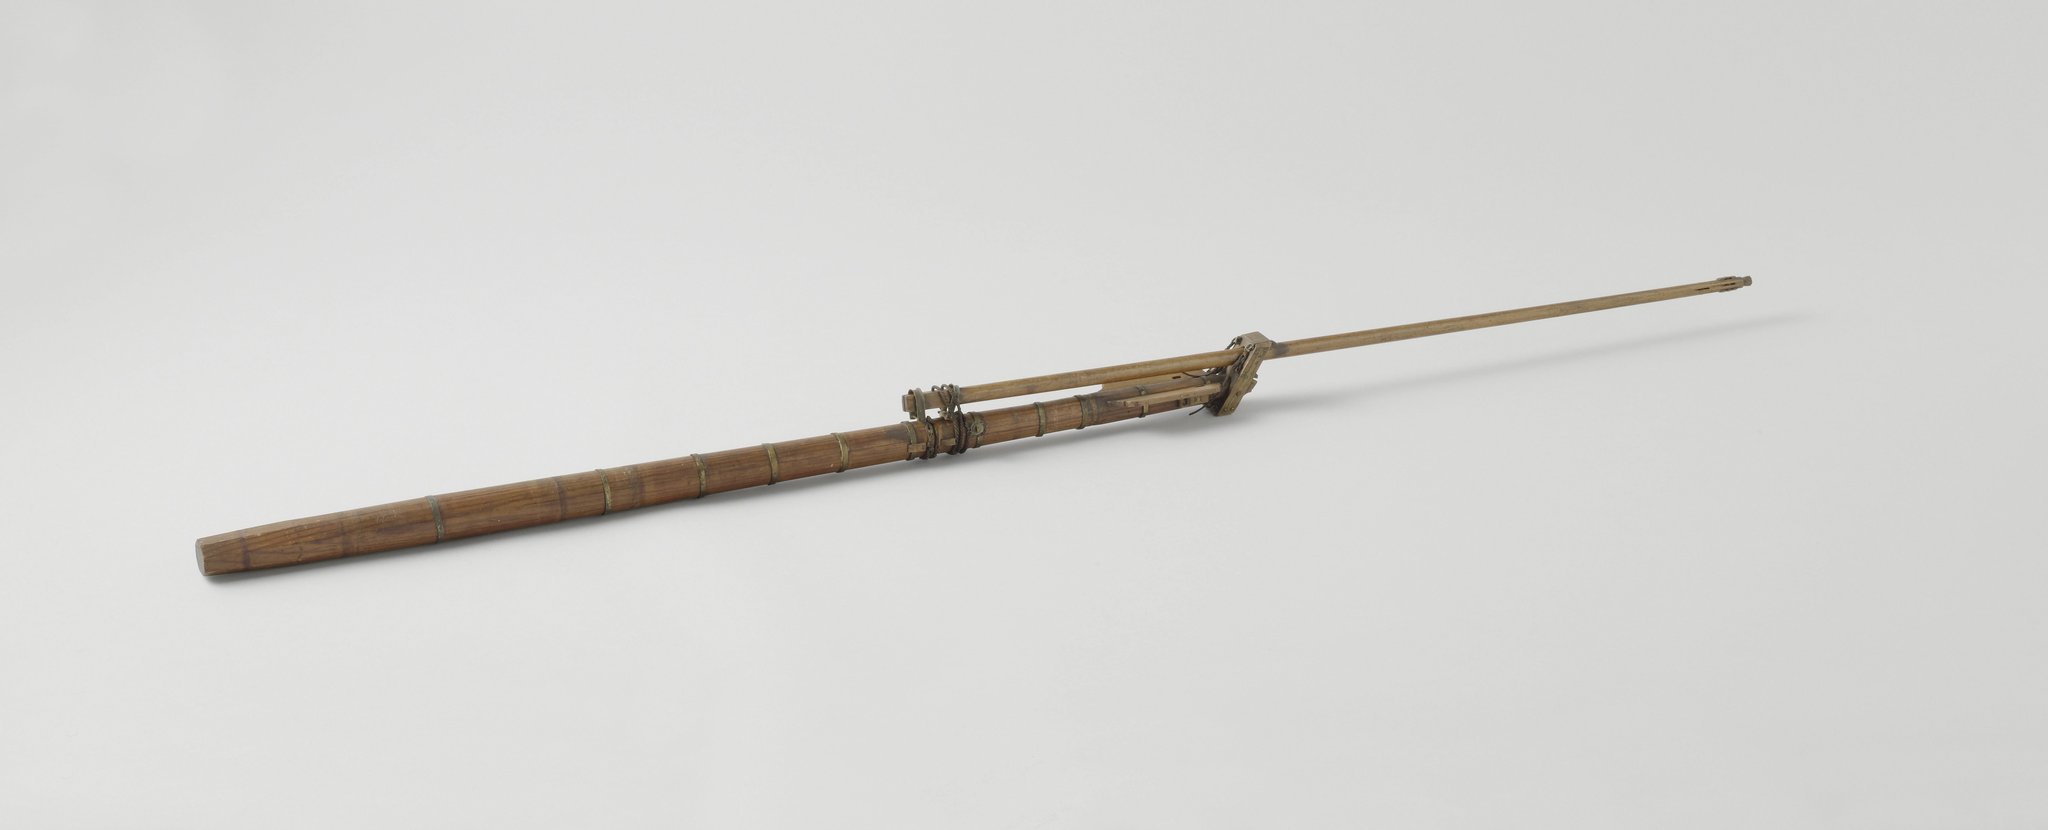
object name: demonstration model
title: Model of a Made Bowsprit and Jibboom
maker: Anonymous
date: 1800-1850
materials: brass, wood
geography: netherlands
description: Ronde boegspriet met kluiverboom. De boegspriet heeft acht wangen, met kuipbanden tegen de koning geklemd. Op ongeveer tweederde van de lengte zijn aan weerszijden twee klampen aangebracht, die de stroppen voor de stagen en de kluiverboom op hun plaats houden. Aan het eind van de boegspriet zit een vioolstuk met daaronder een schijf aan iedere kant. Het schild heeft beugels voor de stampstok en de geussteng; aan de achterkant zijn ogen voor de loopstagen en andere stagen en een blok aangebracht. Het kluifhout heeft vier schijven aan het eind en een voor het schieten aan de voet.